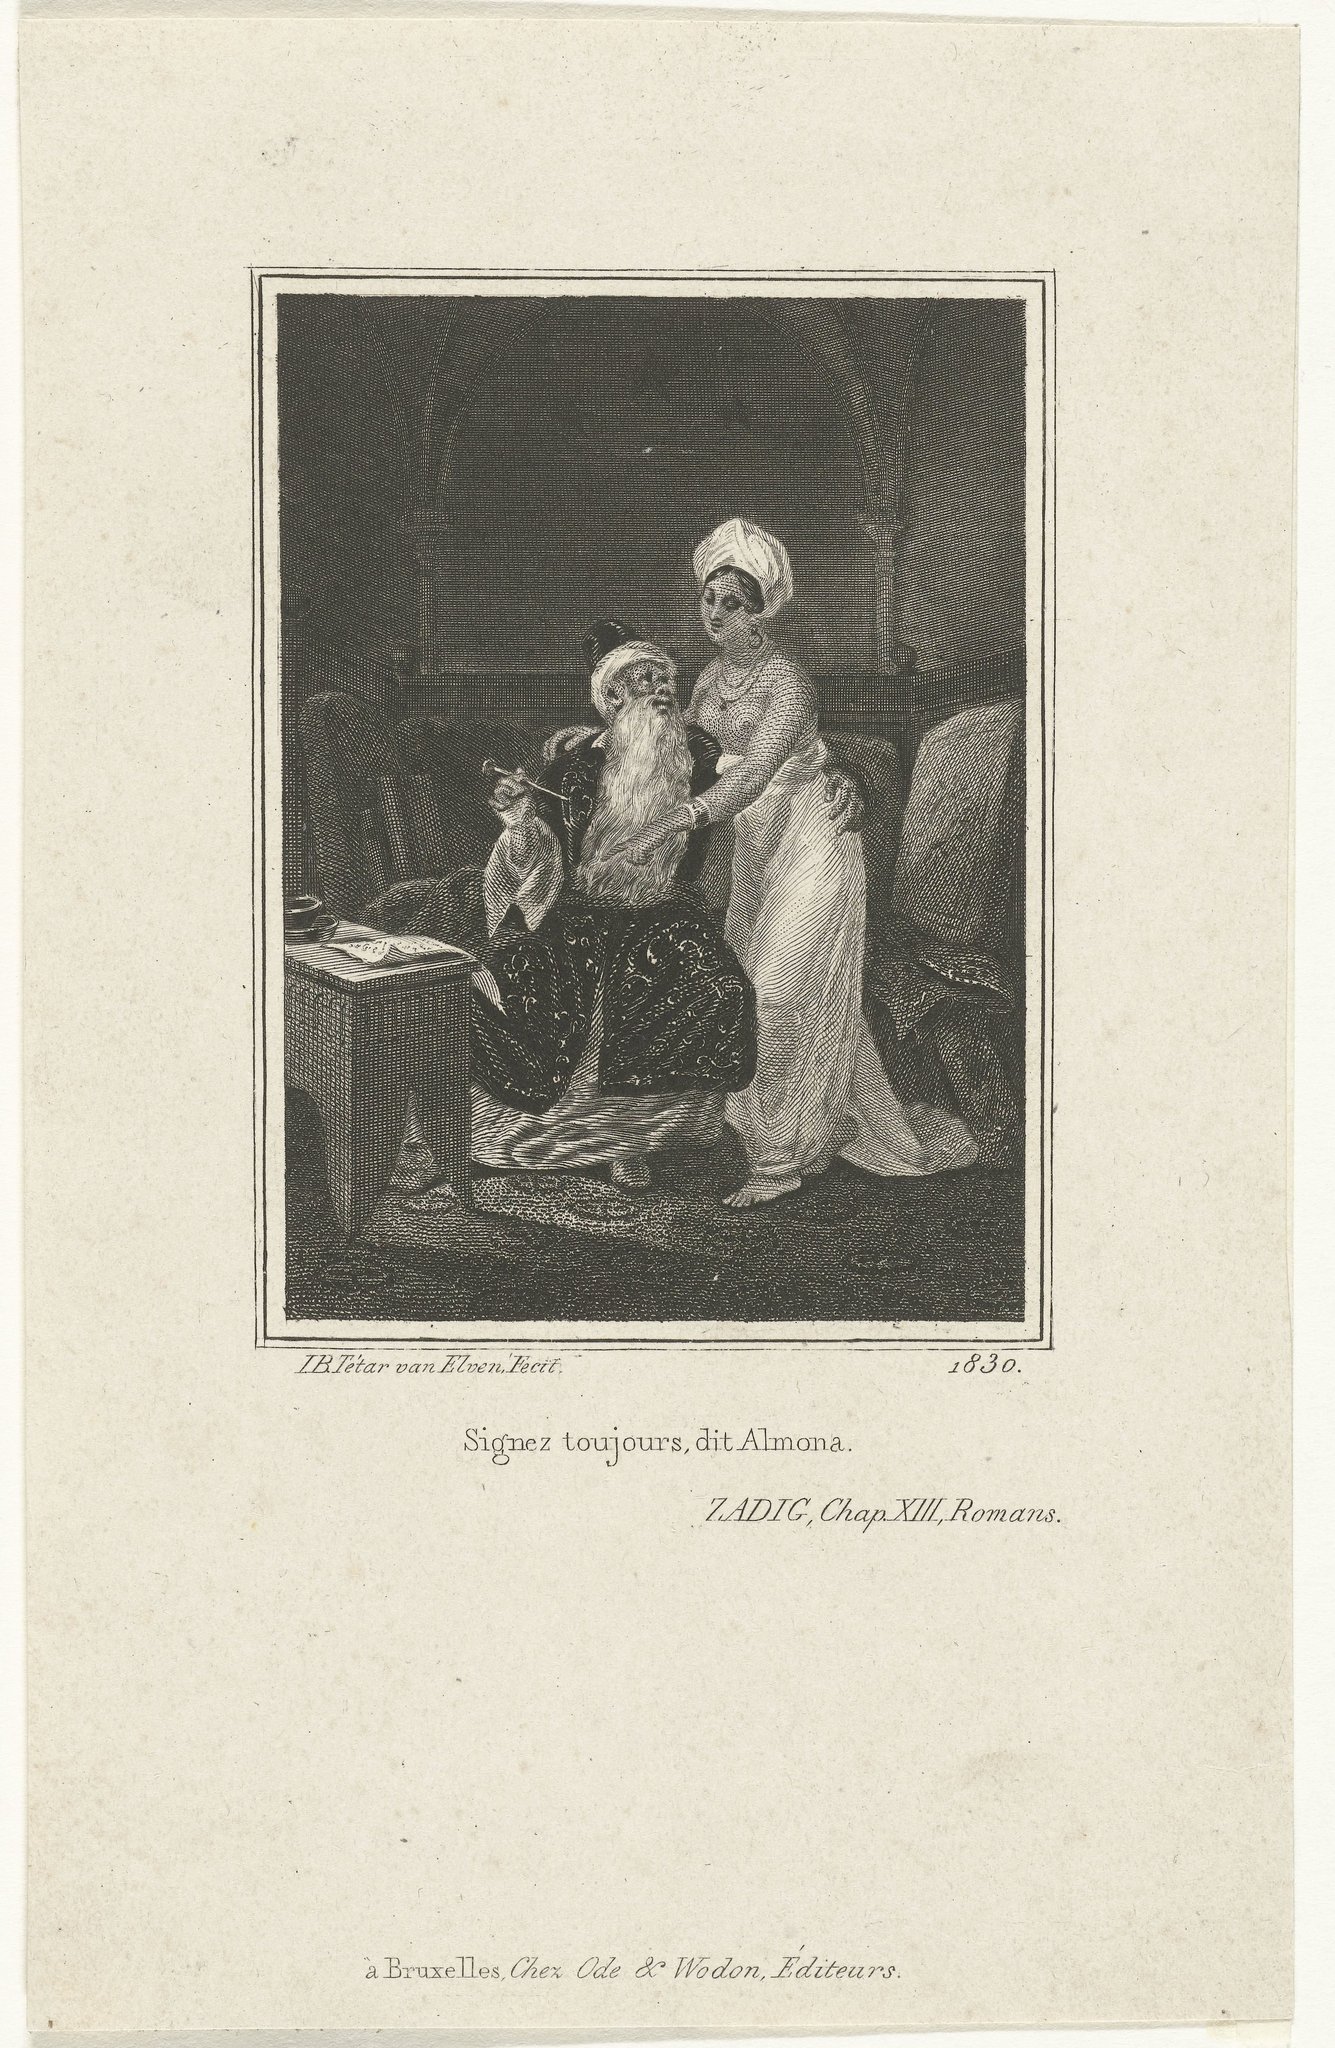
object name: print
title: Zadig en Almona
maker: jan baptist tetar van elven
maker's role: draughtsman, print maker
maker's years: 1805-1889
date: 1830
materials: paper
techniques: engraving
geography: brussels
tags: lovers; courting, flirting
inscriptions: collector's mark: Lugt 2760, collector's mark: Lugt 2228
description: De filosoof Zadig zit achter een buro en slaat zijn arm om de weduwe Almona, met ontbloot bovenlijf. Illustratie bij hoofdstuk 13 van de roman Zadig ou la Destinée, 1747, van Voltaire.